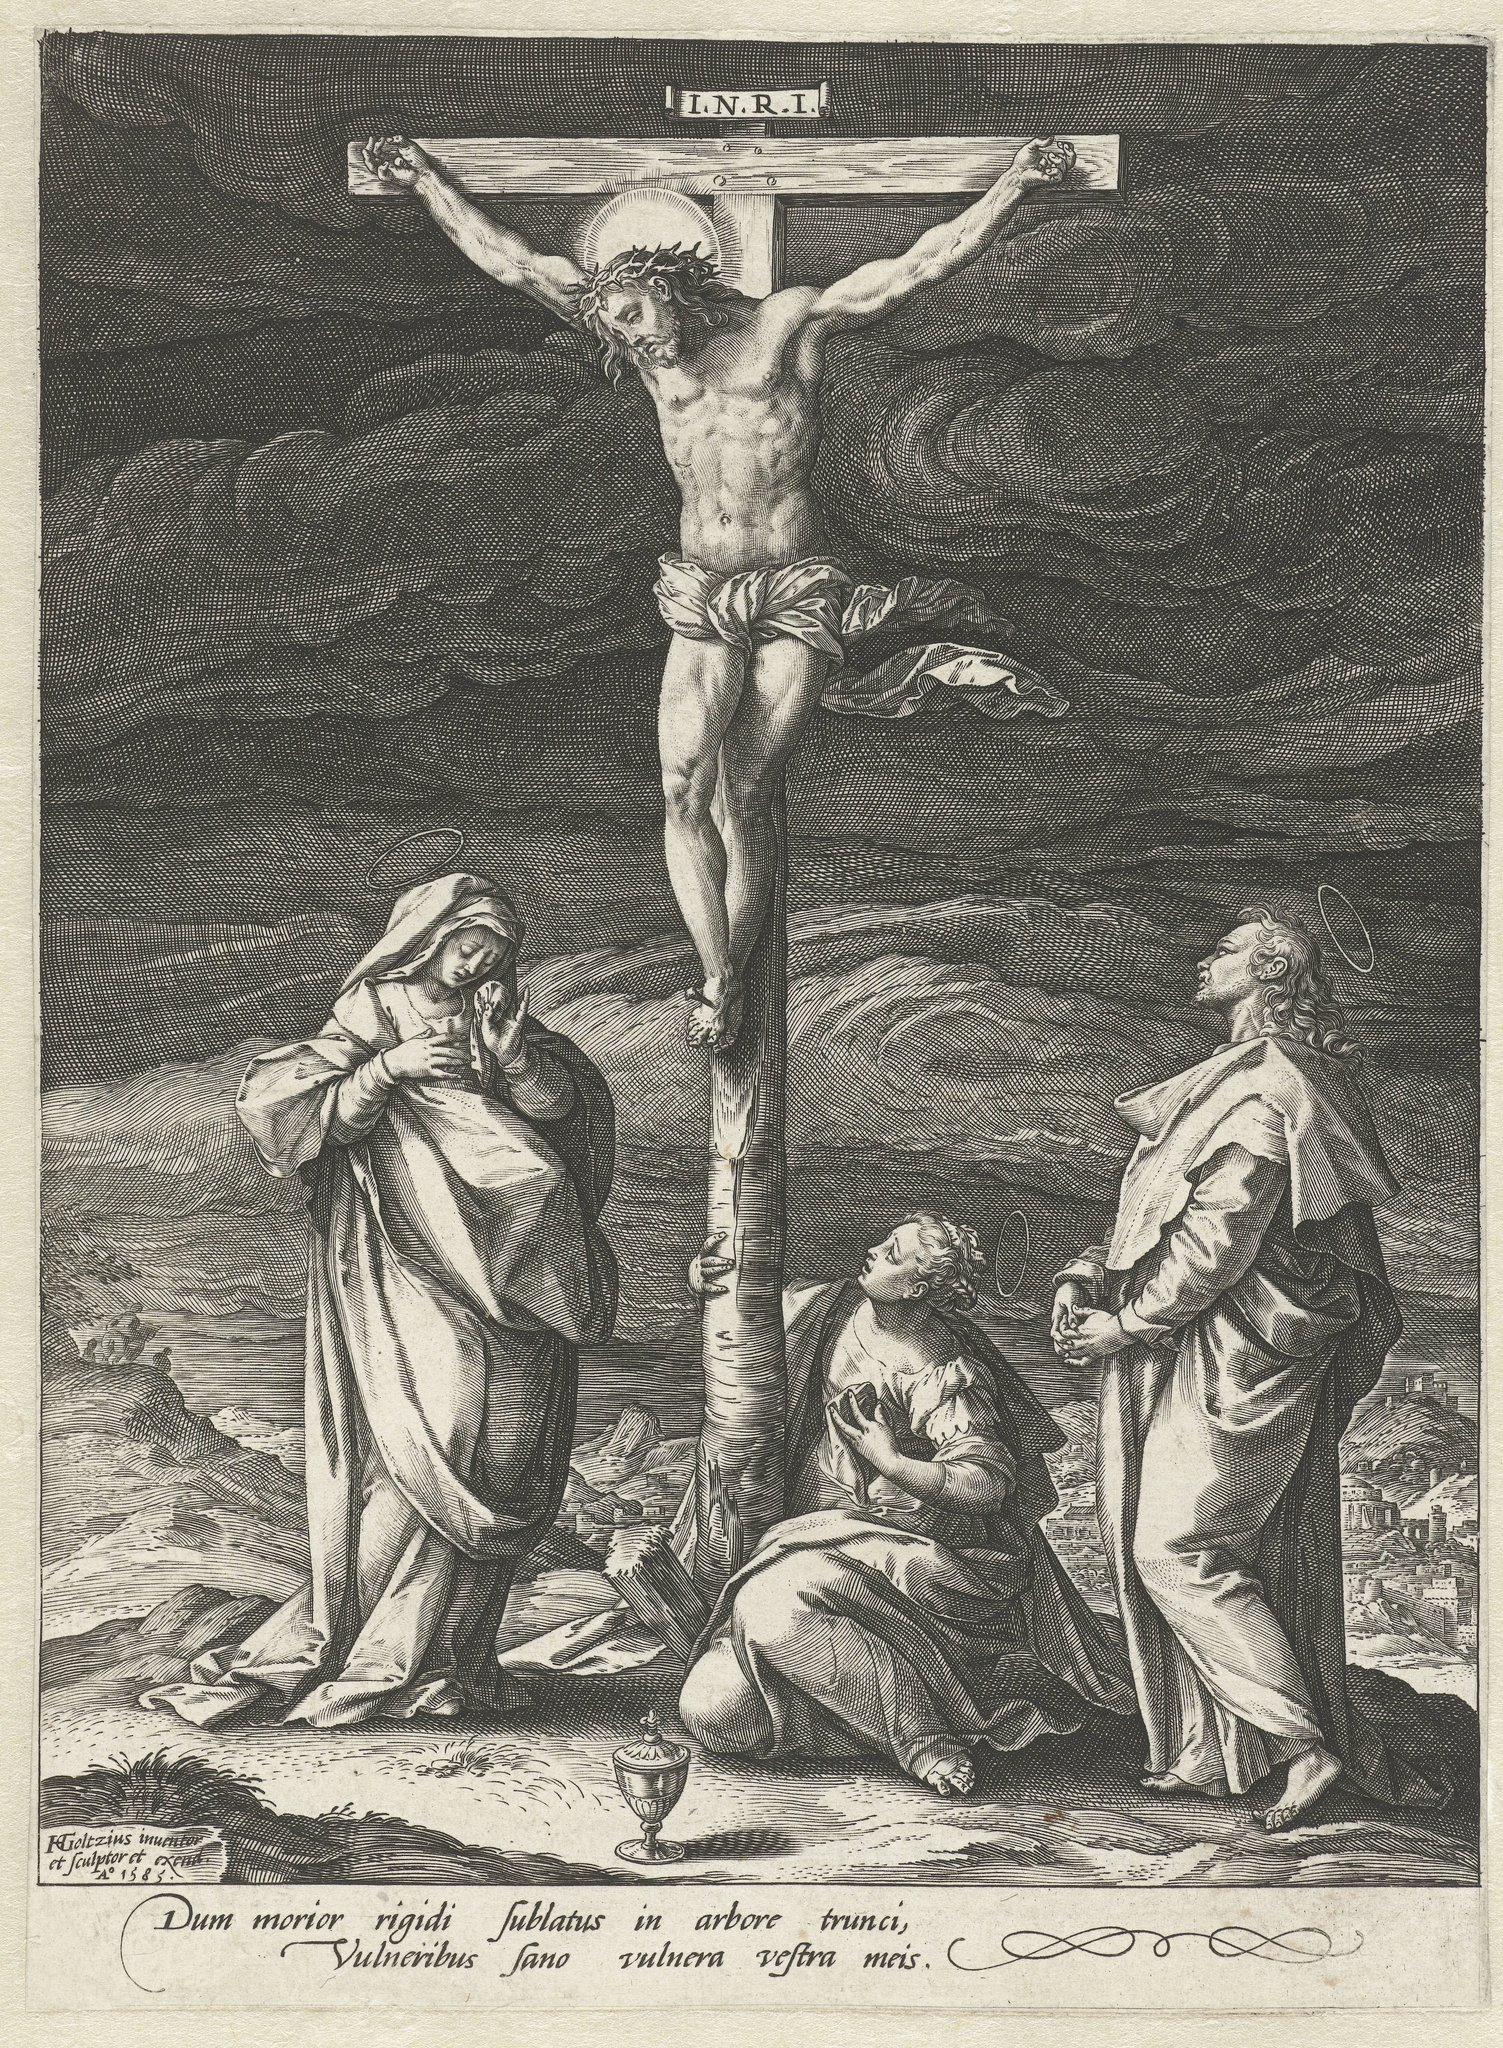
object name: print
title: Kruisiging met Maria, Maria Magdalena en Johannes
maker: hendrick goltzius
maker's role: draughtsman, painter, print maker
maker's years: 1558-1617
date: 1585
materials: paper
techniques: engraving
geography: haarlem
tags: crucified christ with mary, john, and mary magdalene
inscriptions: signature, date and inscription: ‘HGoltzius inventor et sculptor et excud. A o. 1585’, collector's mark: Lugt 240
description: In het midden van de compositie is Christus aan het kruis genageld. Aan de voet van het kruis zit Maria Magdalena. Maria en de apostel (later evangelist) Johannes flankeren het kruis. Jeruzalem op de achtergrond. Twee regels Latijn in marge onder prent.